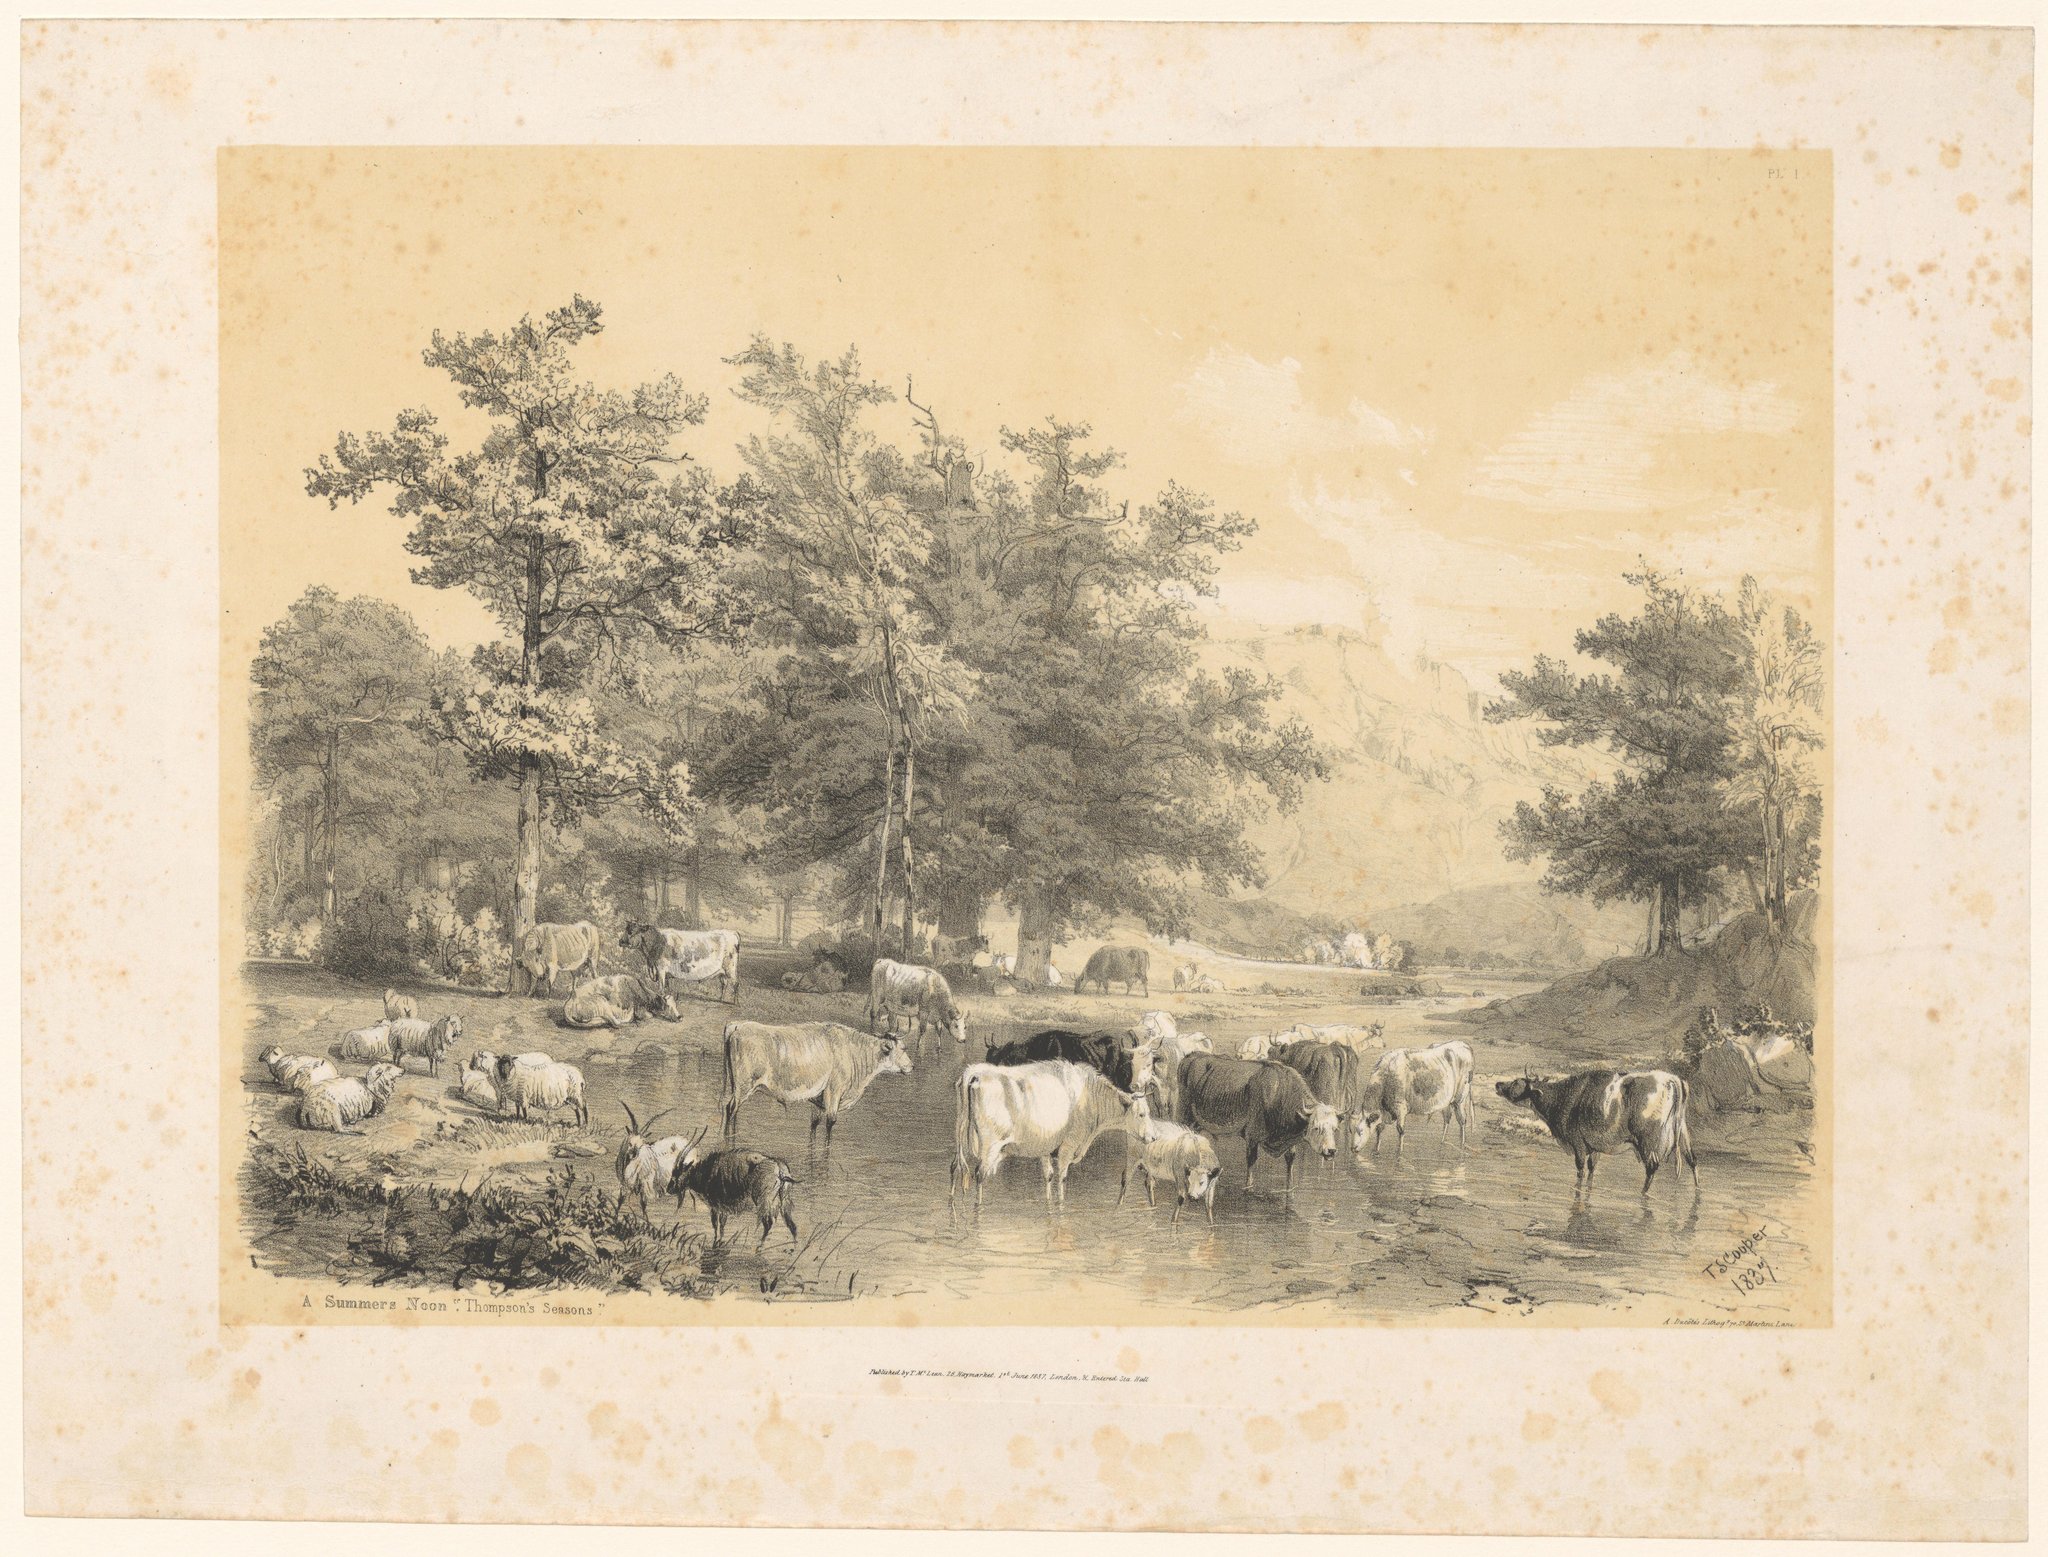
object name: print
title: Runderen, schapen en geiten bij een waterplas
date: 1837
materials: paper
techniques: tone lithography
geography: london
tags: cattle, water course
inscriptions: collector's mark: Lugt 2228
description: Prent behoort mogelijk tot de serie 'Thirty-four subjects of cattle & c. Designs for pictures'.